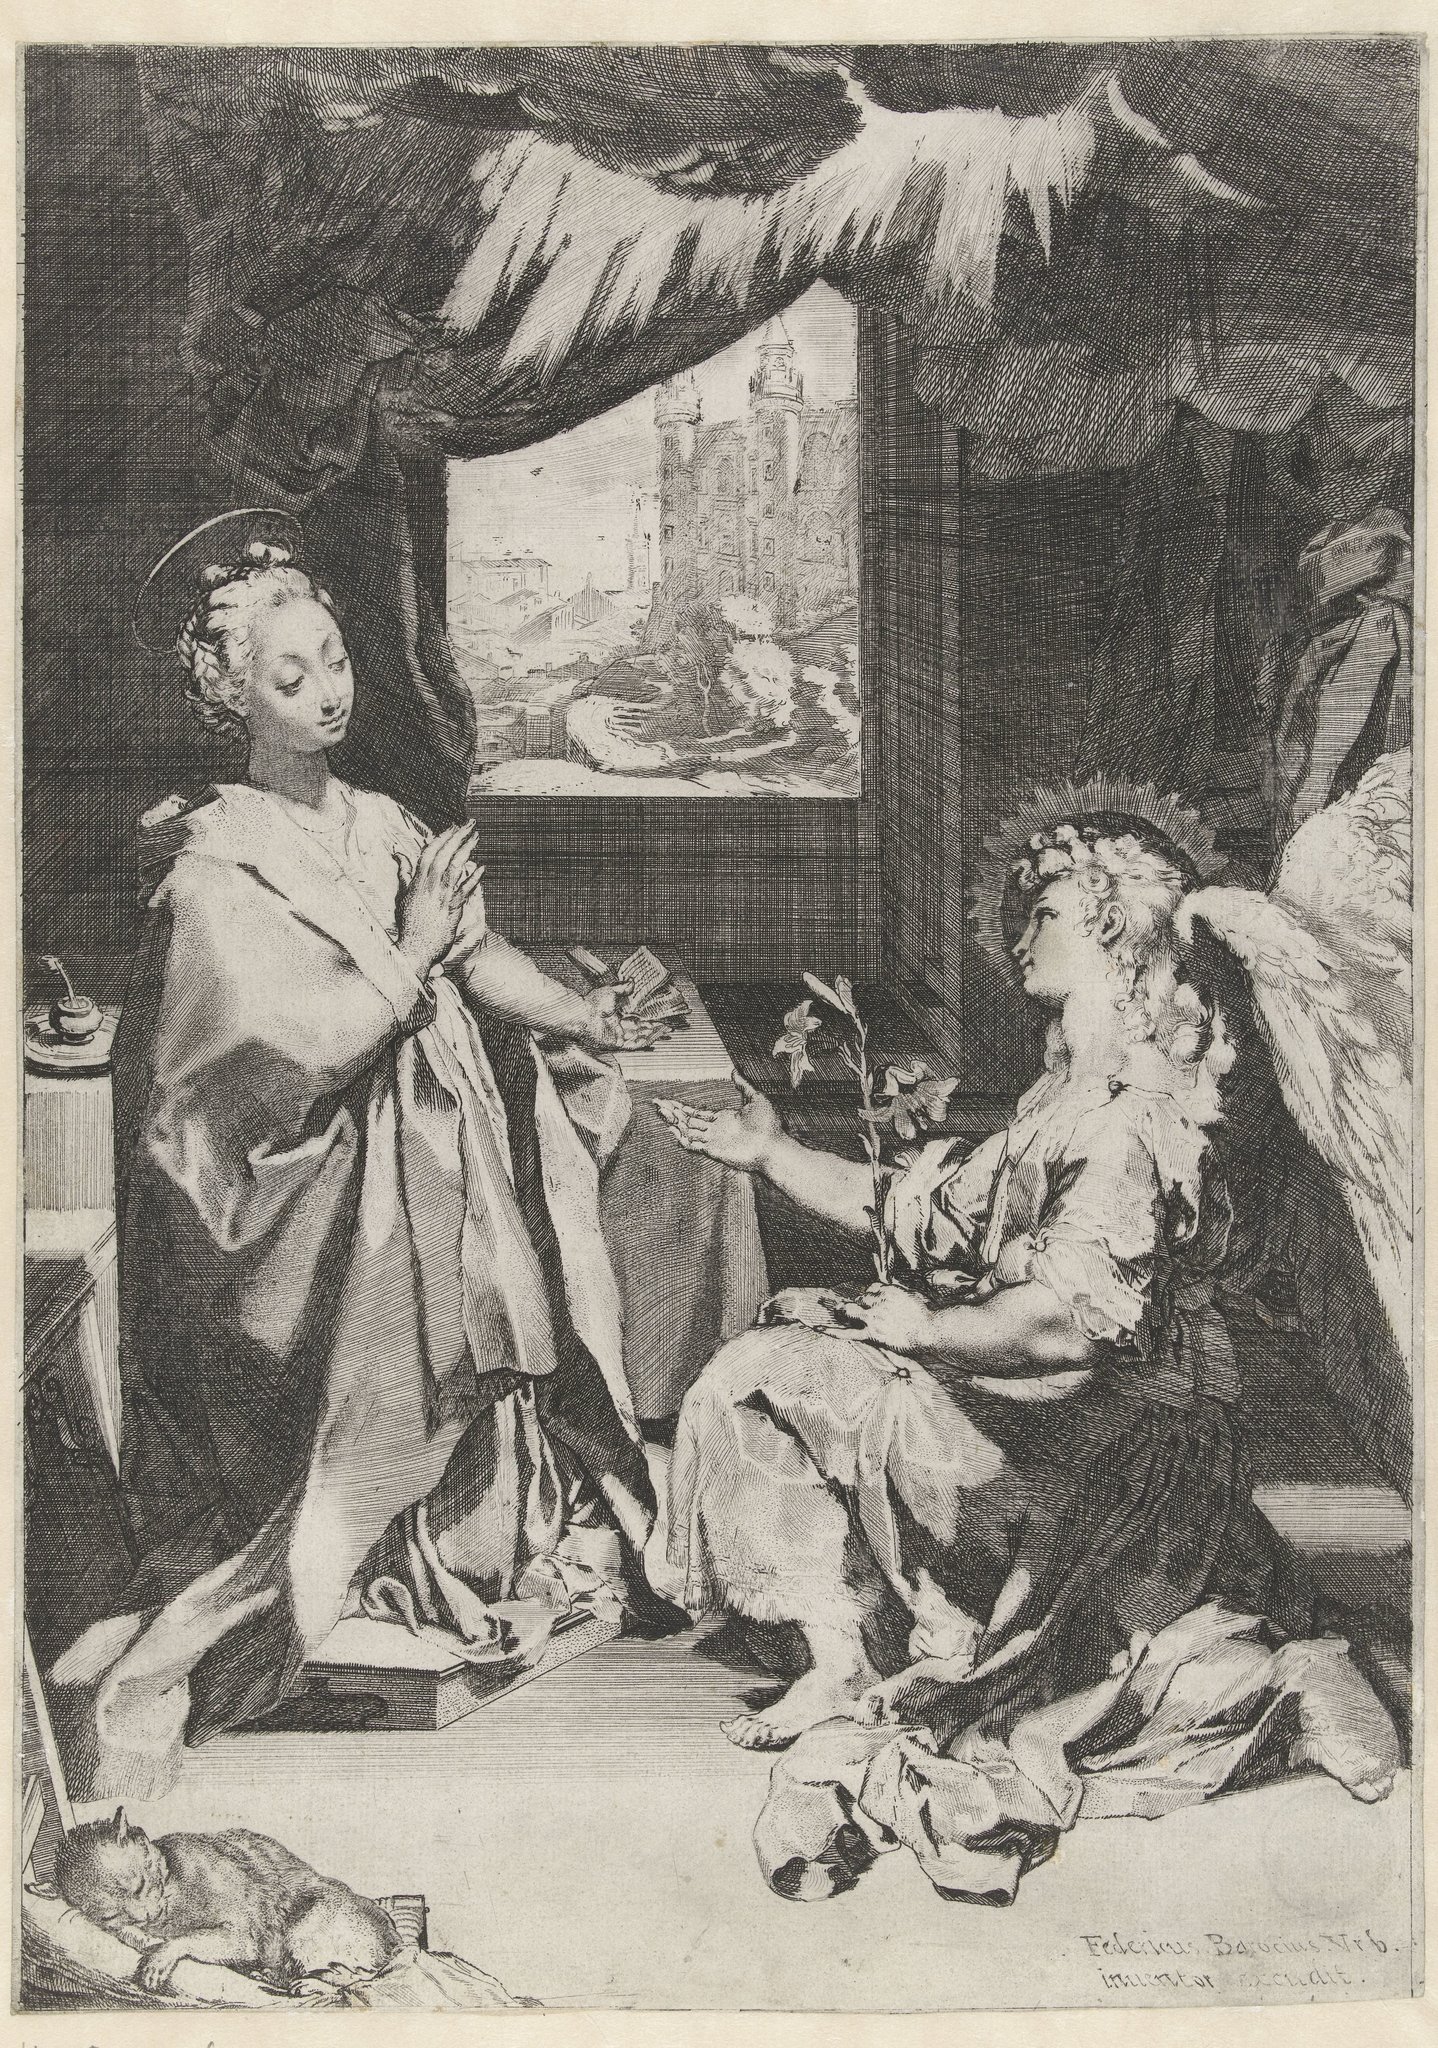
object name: print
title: Annunciatie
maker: federico barocci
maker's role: draughtsman, painter, print maker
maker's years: 1528-1612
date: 1584-1588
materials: paper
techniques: drypoint, engraving, etching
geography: urbino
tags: the annunciation: mary kneeling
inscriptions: collector's mark: Lugt 10, collector's mark: Lugt 11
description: De engel Gabriël, een lelie in de hand, knielt voor Maria, die op de knieën in een vertrek bij een tafeltje zit. Links op de voorgrond een slapende poes. Op de achtergrond, door een raam te zien, een kasteel.